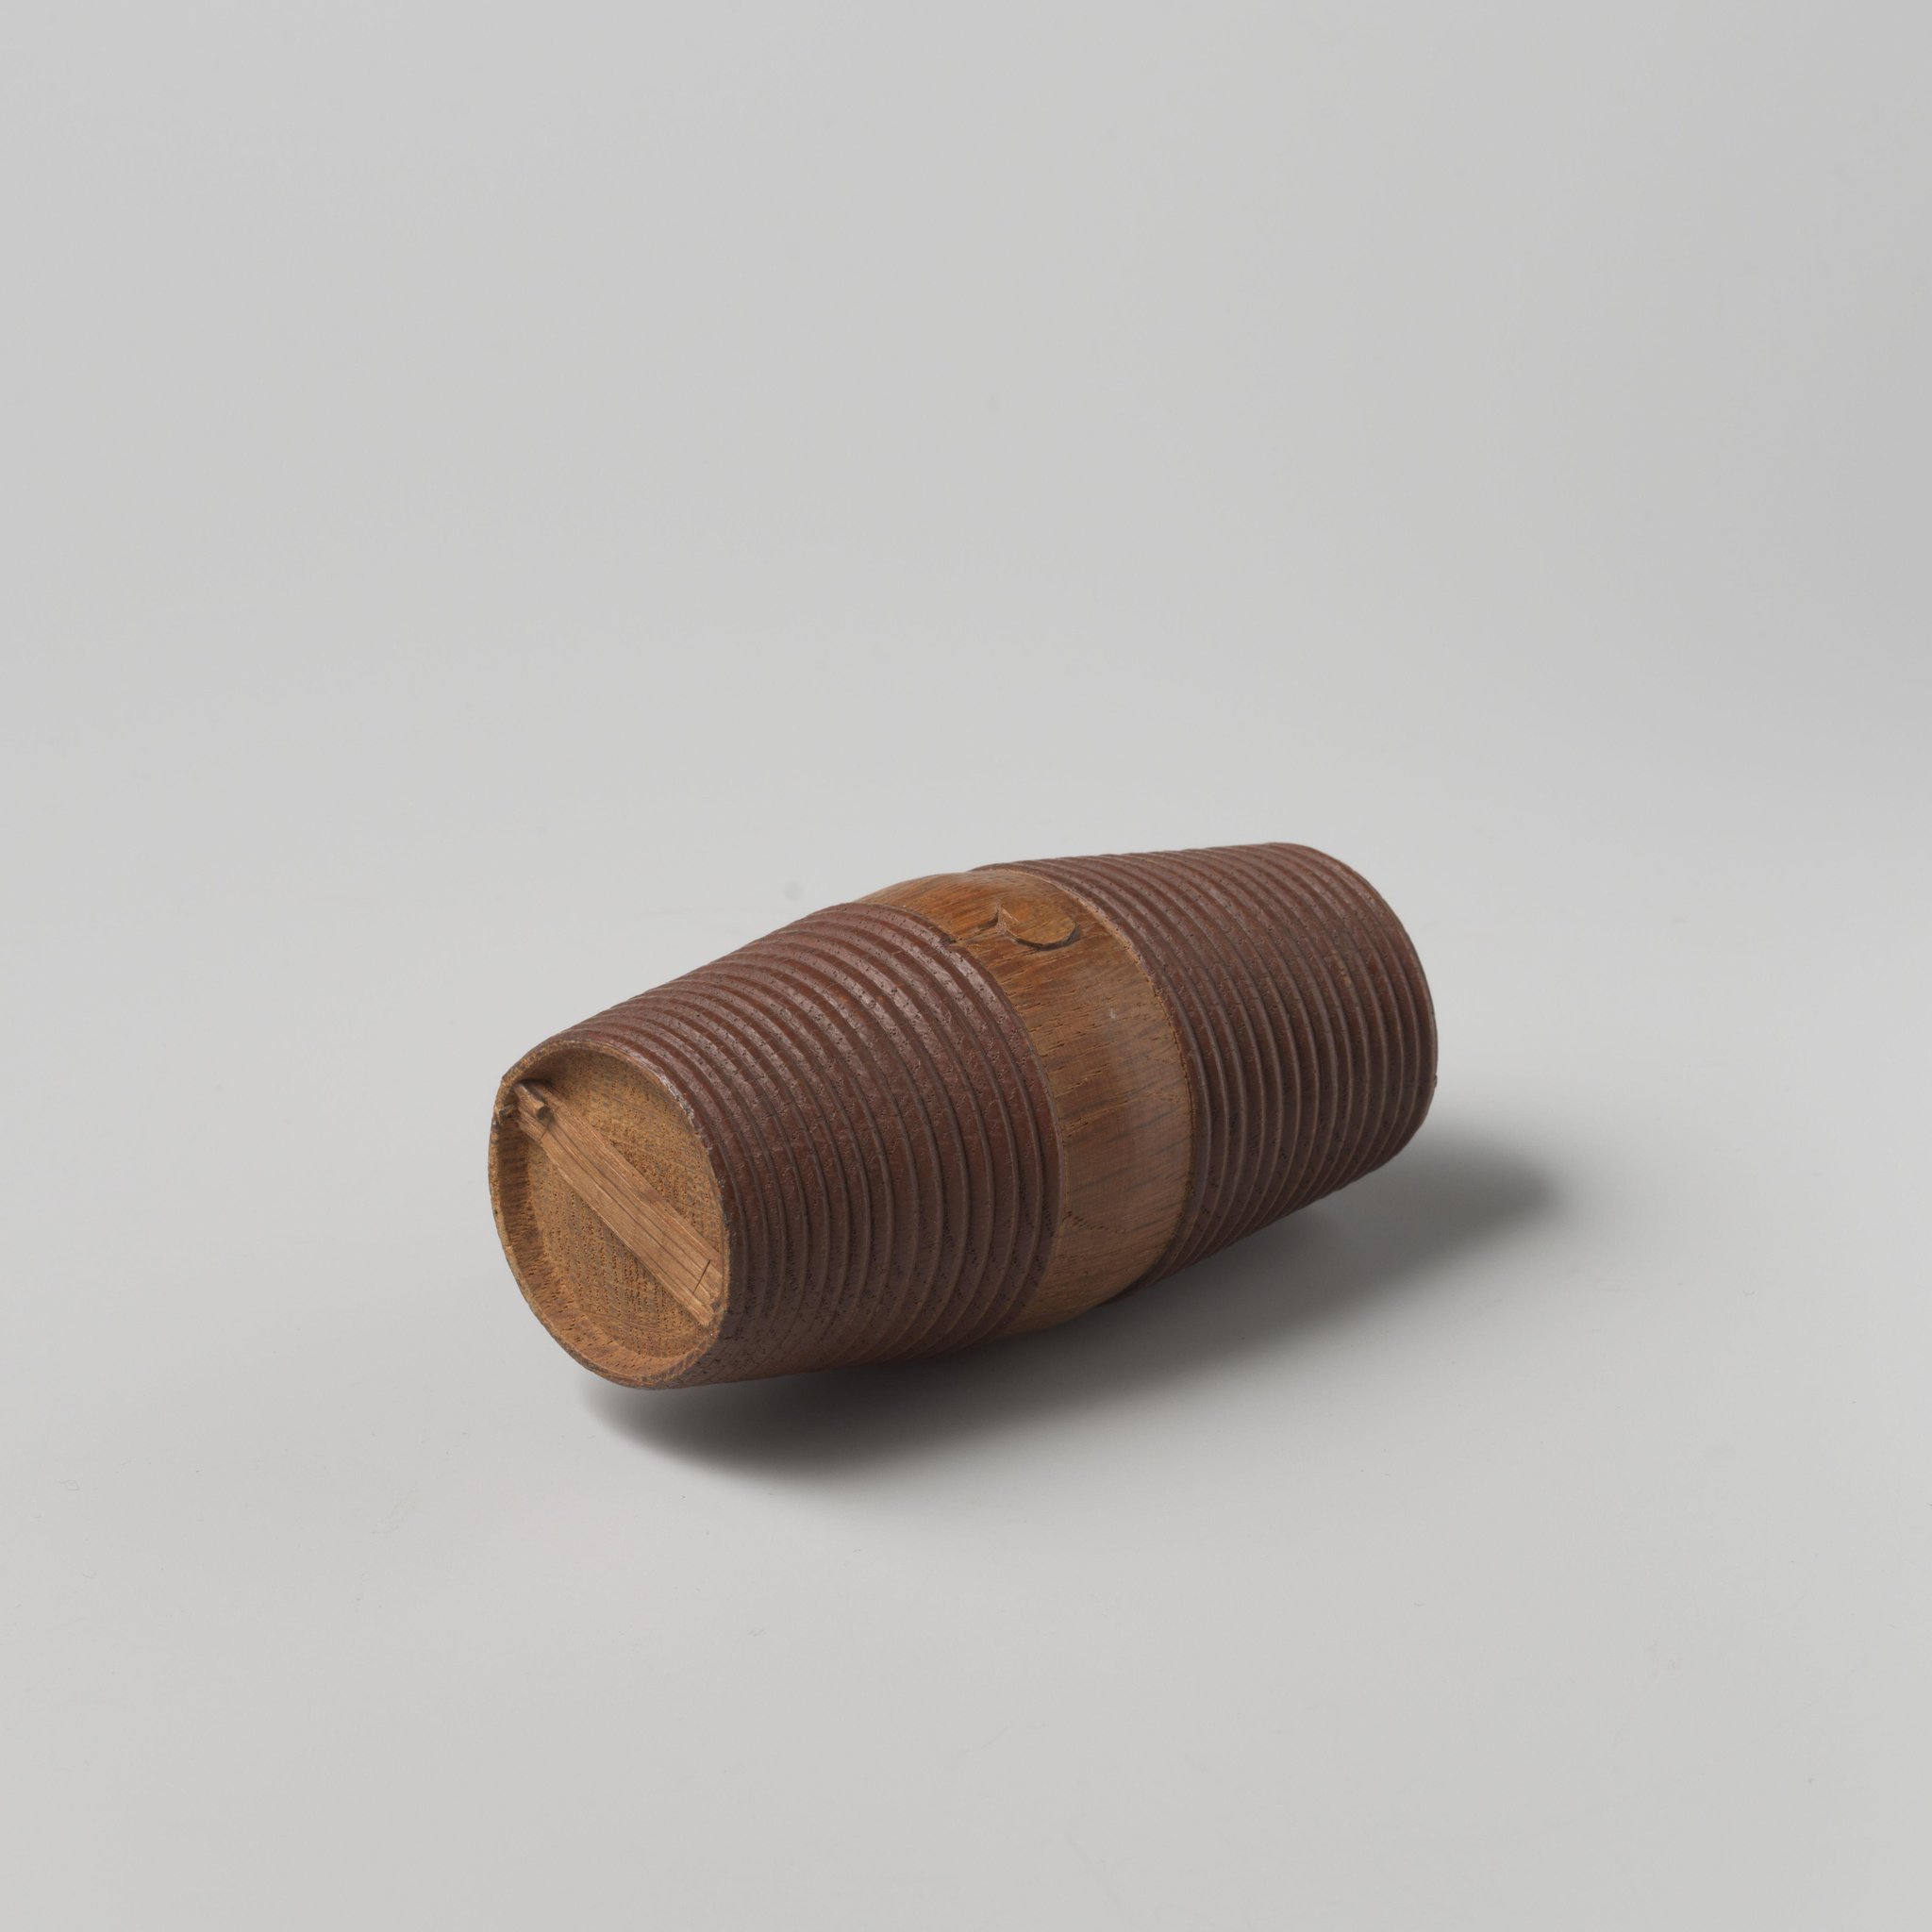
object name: wijnvat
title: Wijnvat van eikenhout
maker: Anonymous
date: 1676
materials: wood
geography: amsterdam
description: Wijnvat van eikenhout, gedraaid uit een massief blok hout, met ringen (hoepels voorstellende), een spongat met stop bovenop, en een gat voor een tapkraan in de voorzijde. De ronde voor en achterplaat van de vaten worden extra vastgeklemd door een latje dat door twee maal twee wiggen wordt vastgezet.